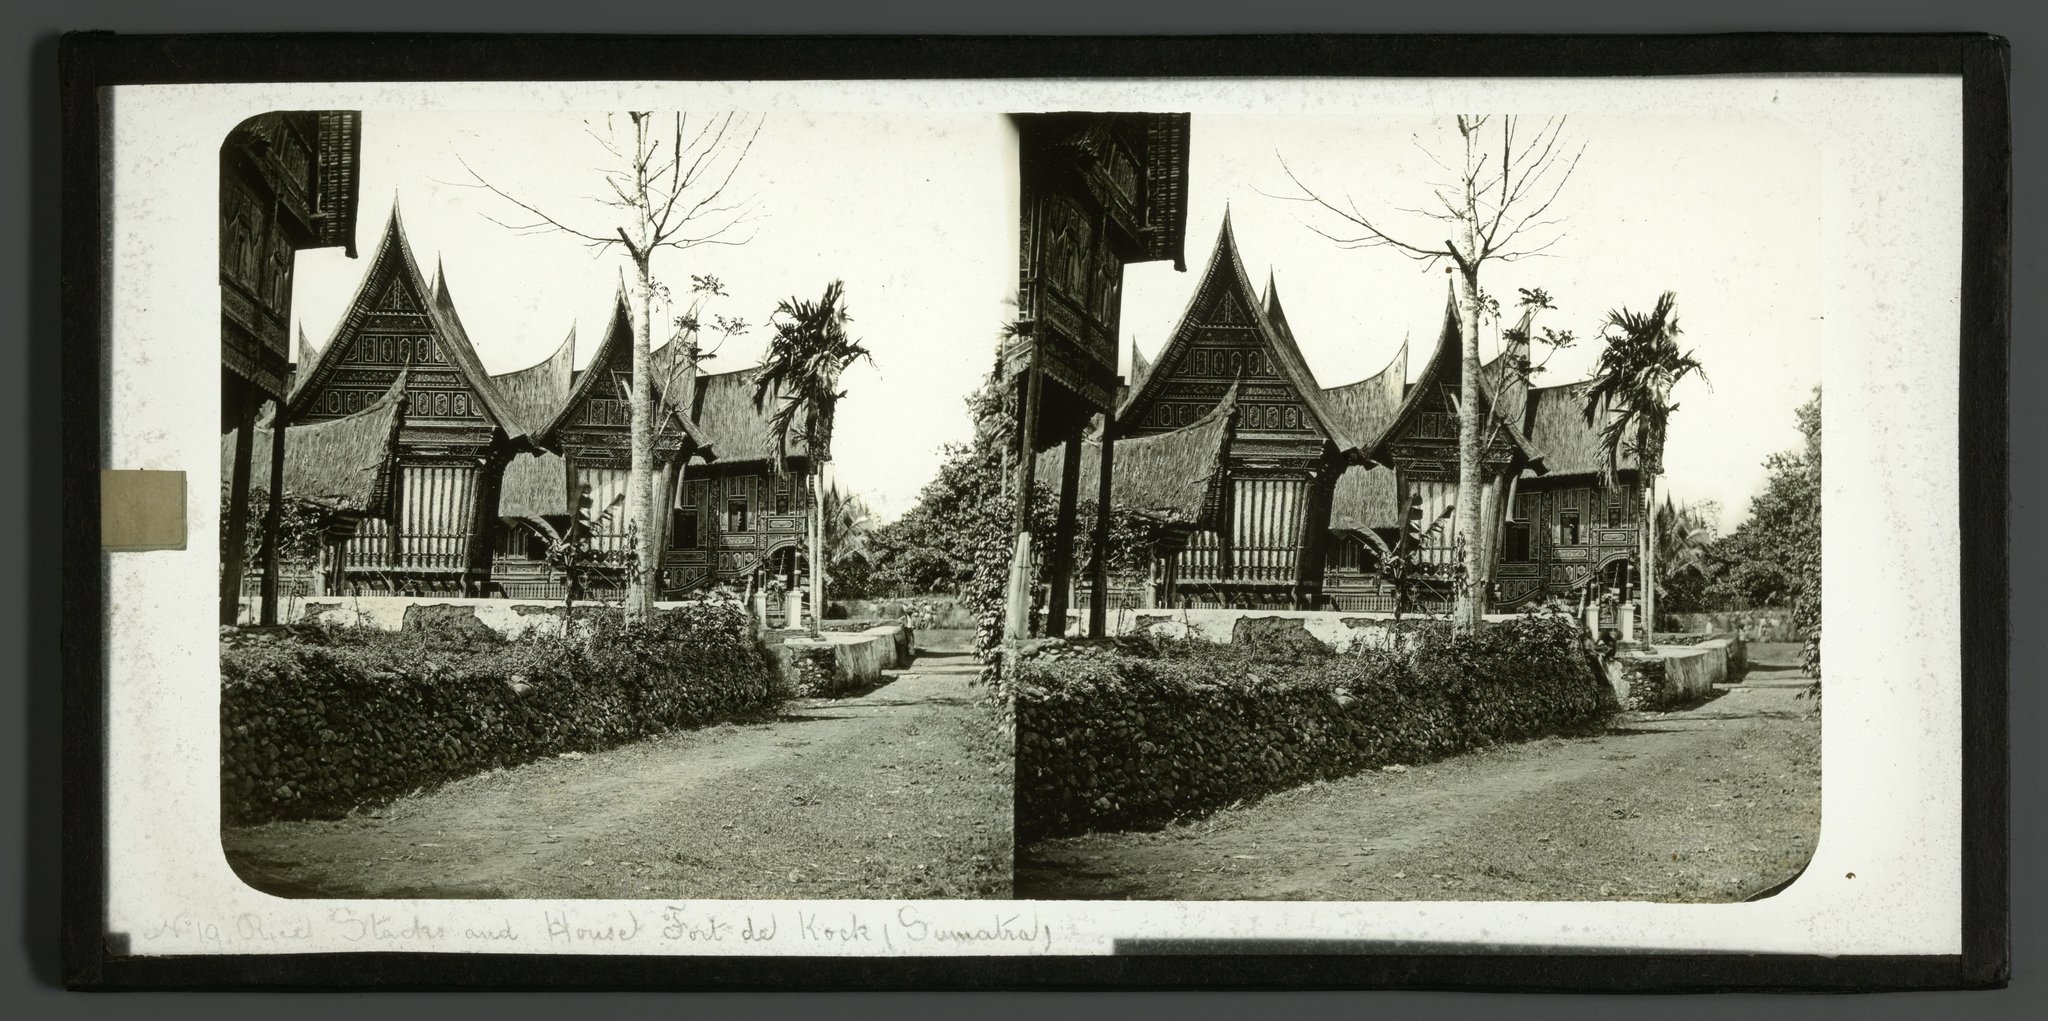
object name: stereoscopic photograph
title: Gezicht op Fort de Kock in Bukittinggi, Sumatra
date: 1857-1864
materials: glass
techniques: slide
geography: sumatra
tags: fortress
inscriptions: number: ‘No 19.’